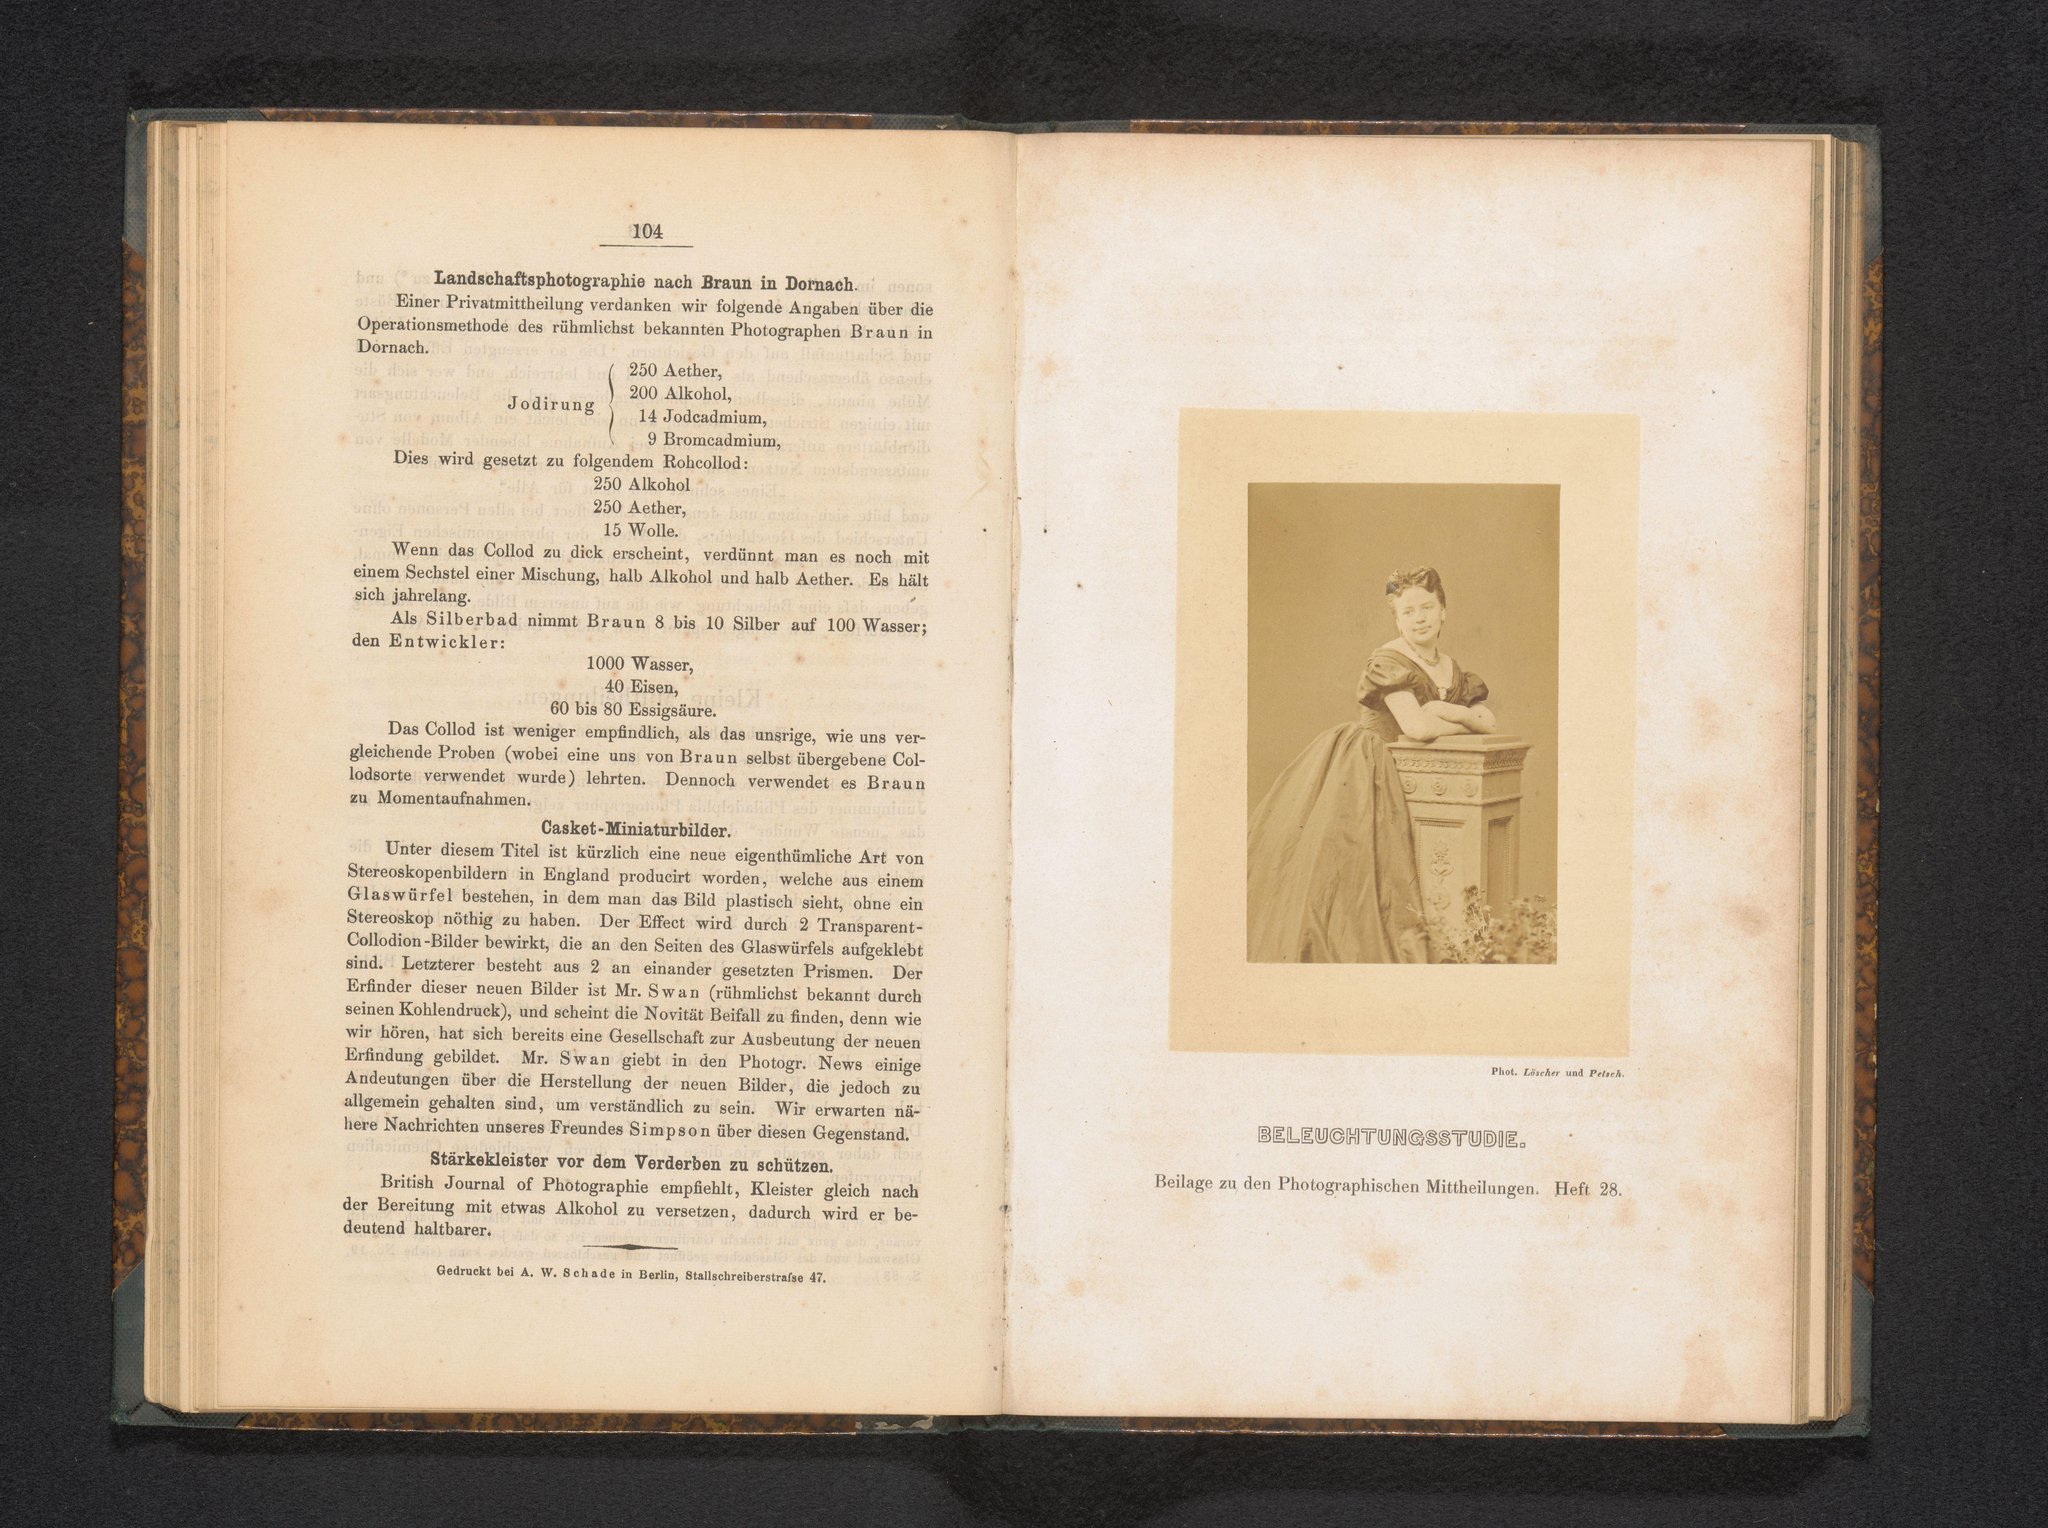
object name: photograph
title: Beleuchtungsstudie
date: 1862-1867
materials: photographic support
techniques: albumen print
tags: adult woman, capital (~ column, pillar)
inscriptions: inscription: ‘Beilage zu den Photograpischen Mittheilungen Heft 28.’